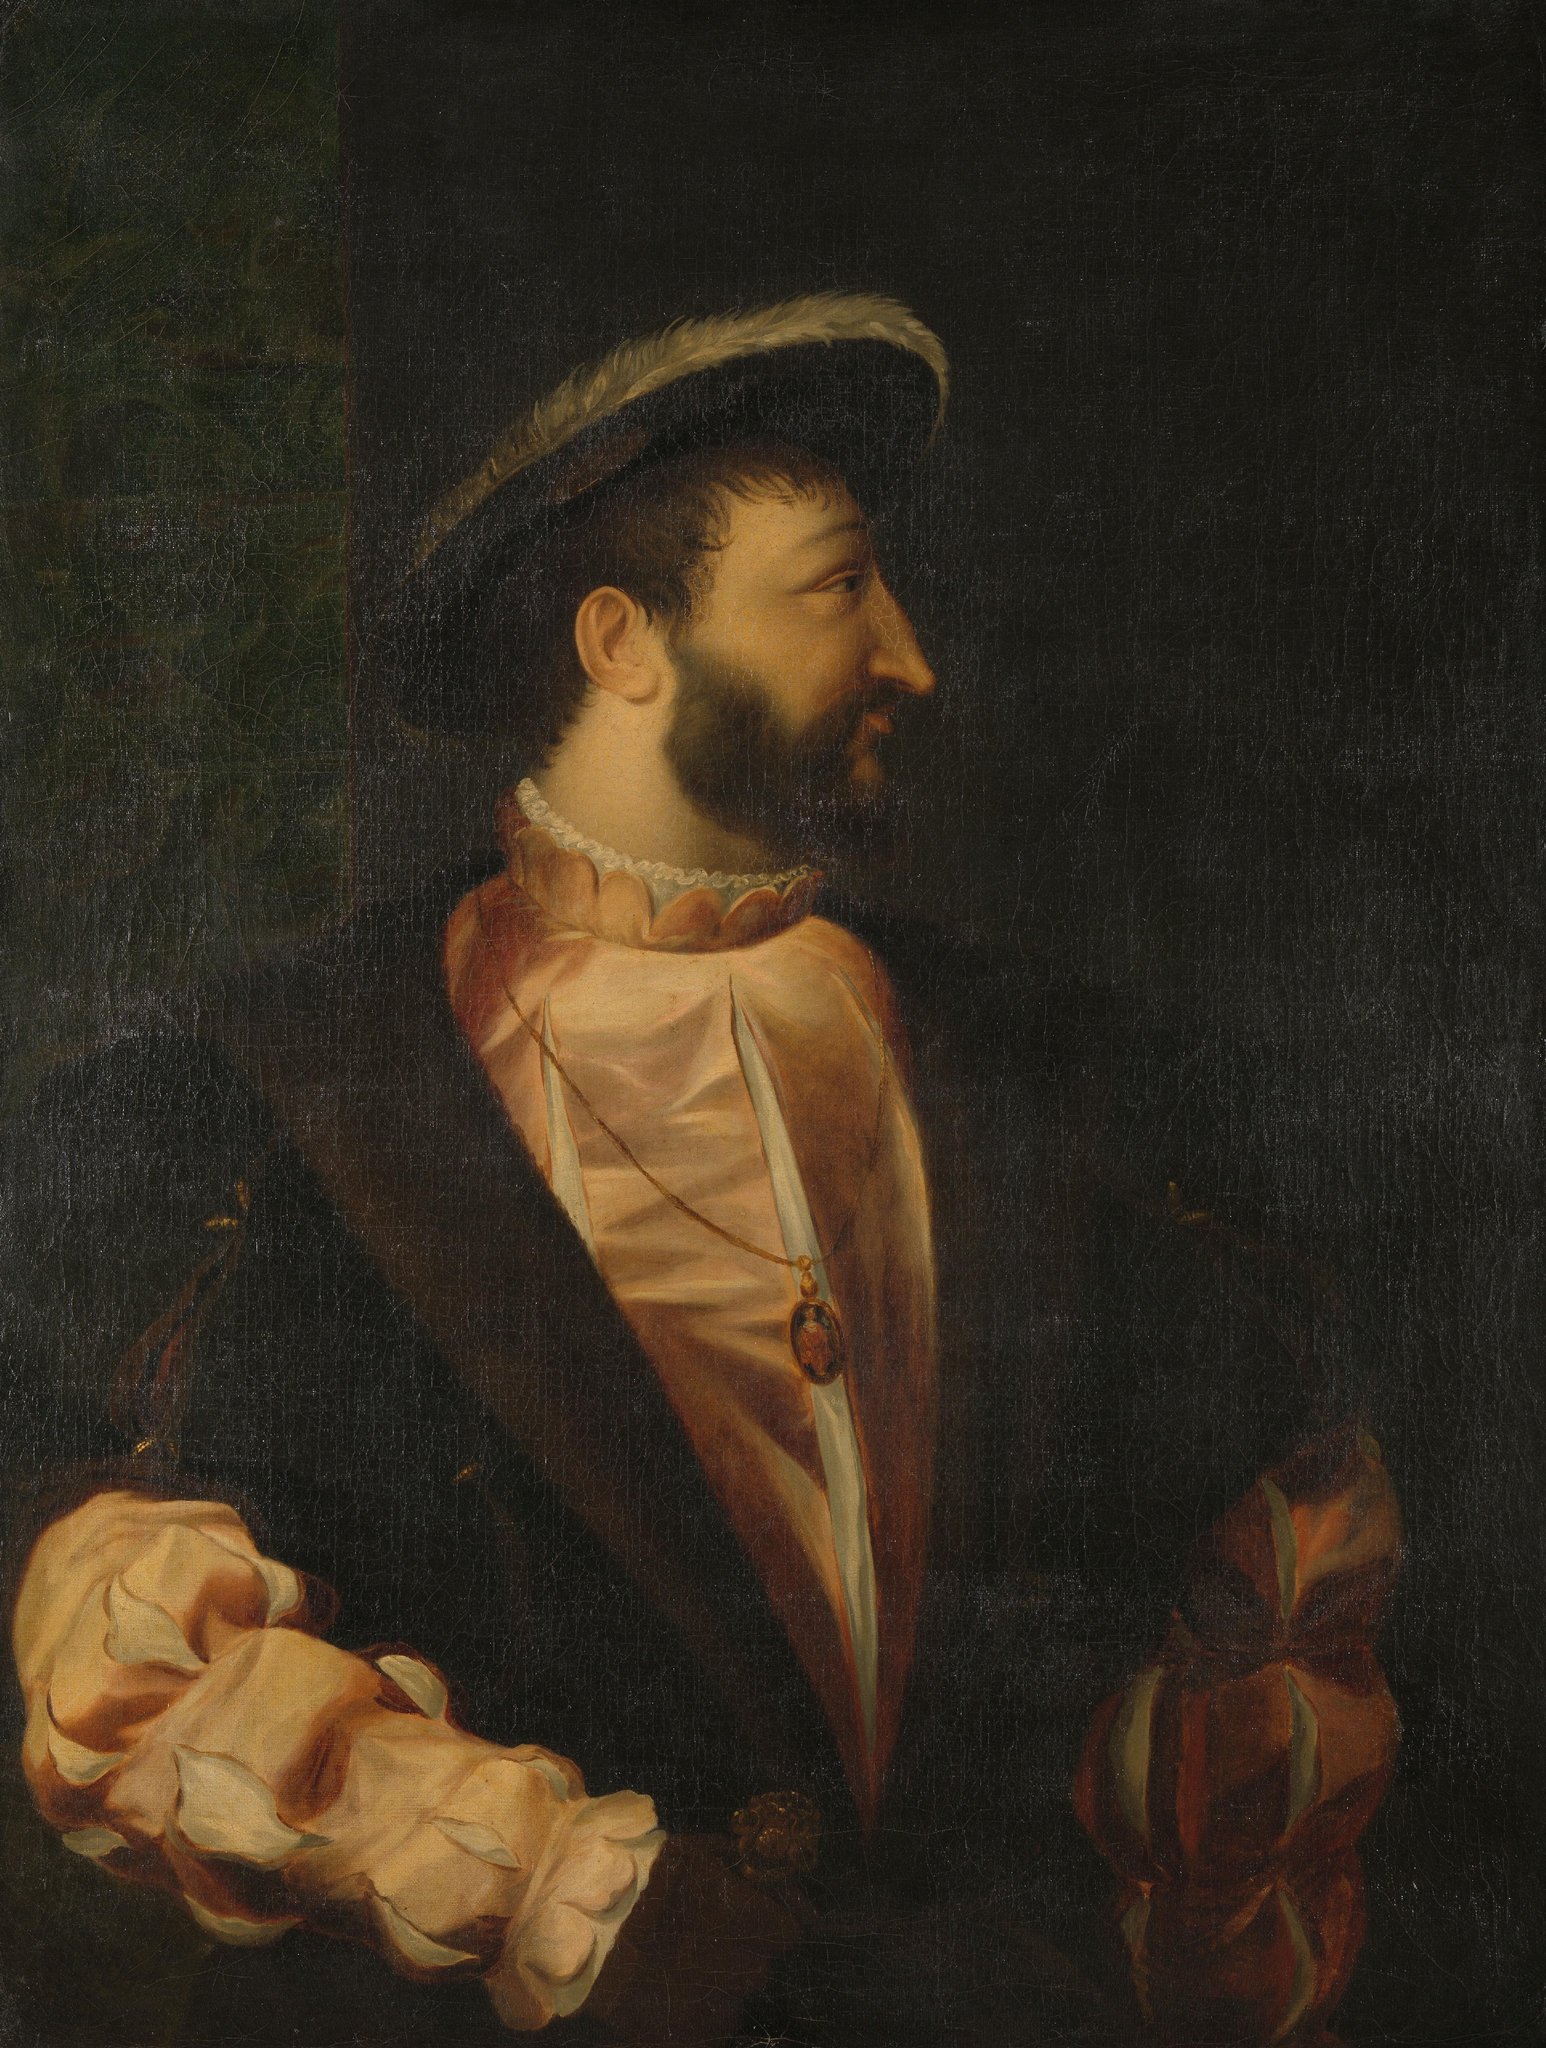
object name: painting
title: Francis I (1494-1547), King of France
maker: benjamin wolff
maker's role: draughtsman, painter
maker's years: 1758-1825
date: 1809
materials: canvas, oil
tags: frans i van valois-angoulême (koning van frankrijk), historical persons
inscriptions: signature, date and inscription: ‘B. Wolff fec. après le Titien à Paris 1809’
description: Portret van Frans I (1494-1547), koning van Frankrijk. Ten halven lijve, in profiel naar rechts. Kopie naar het origineel in het Louvre te Parijs.